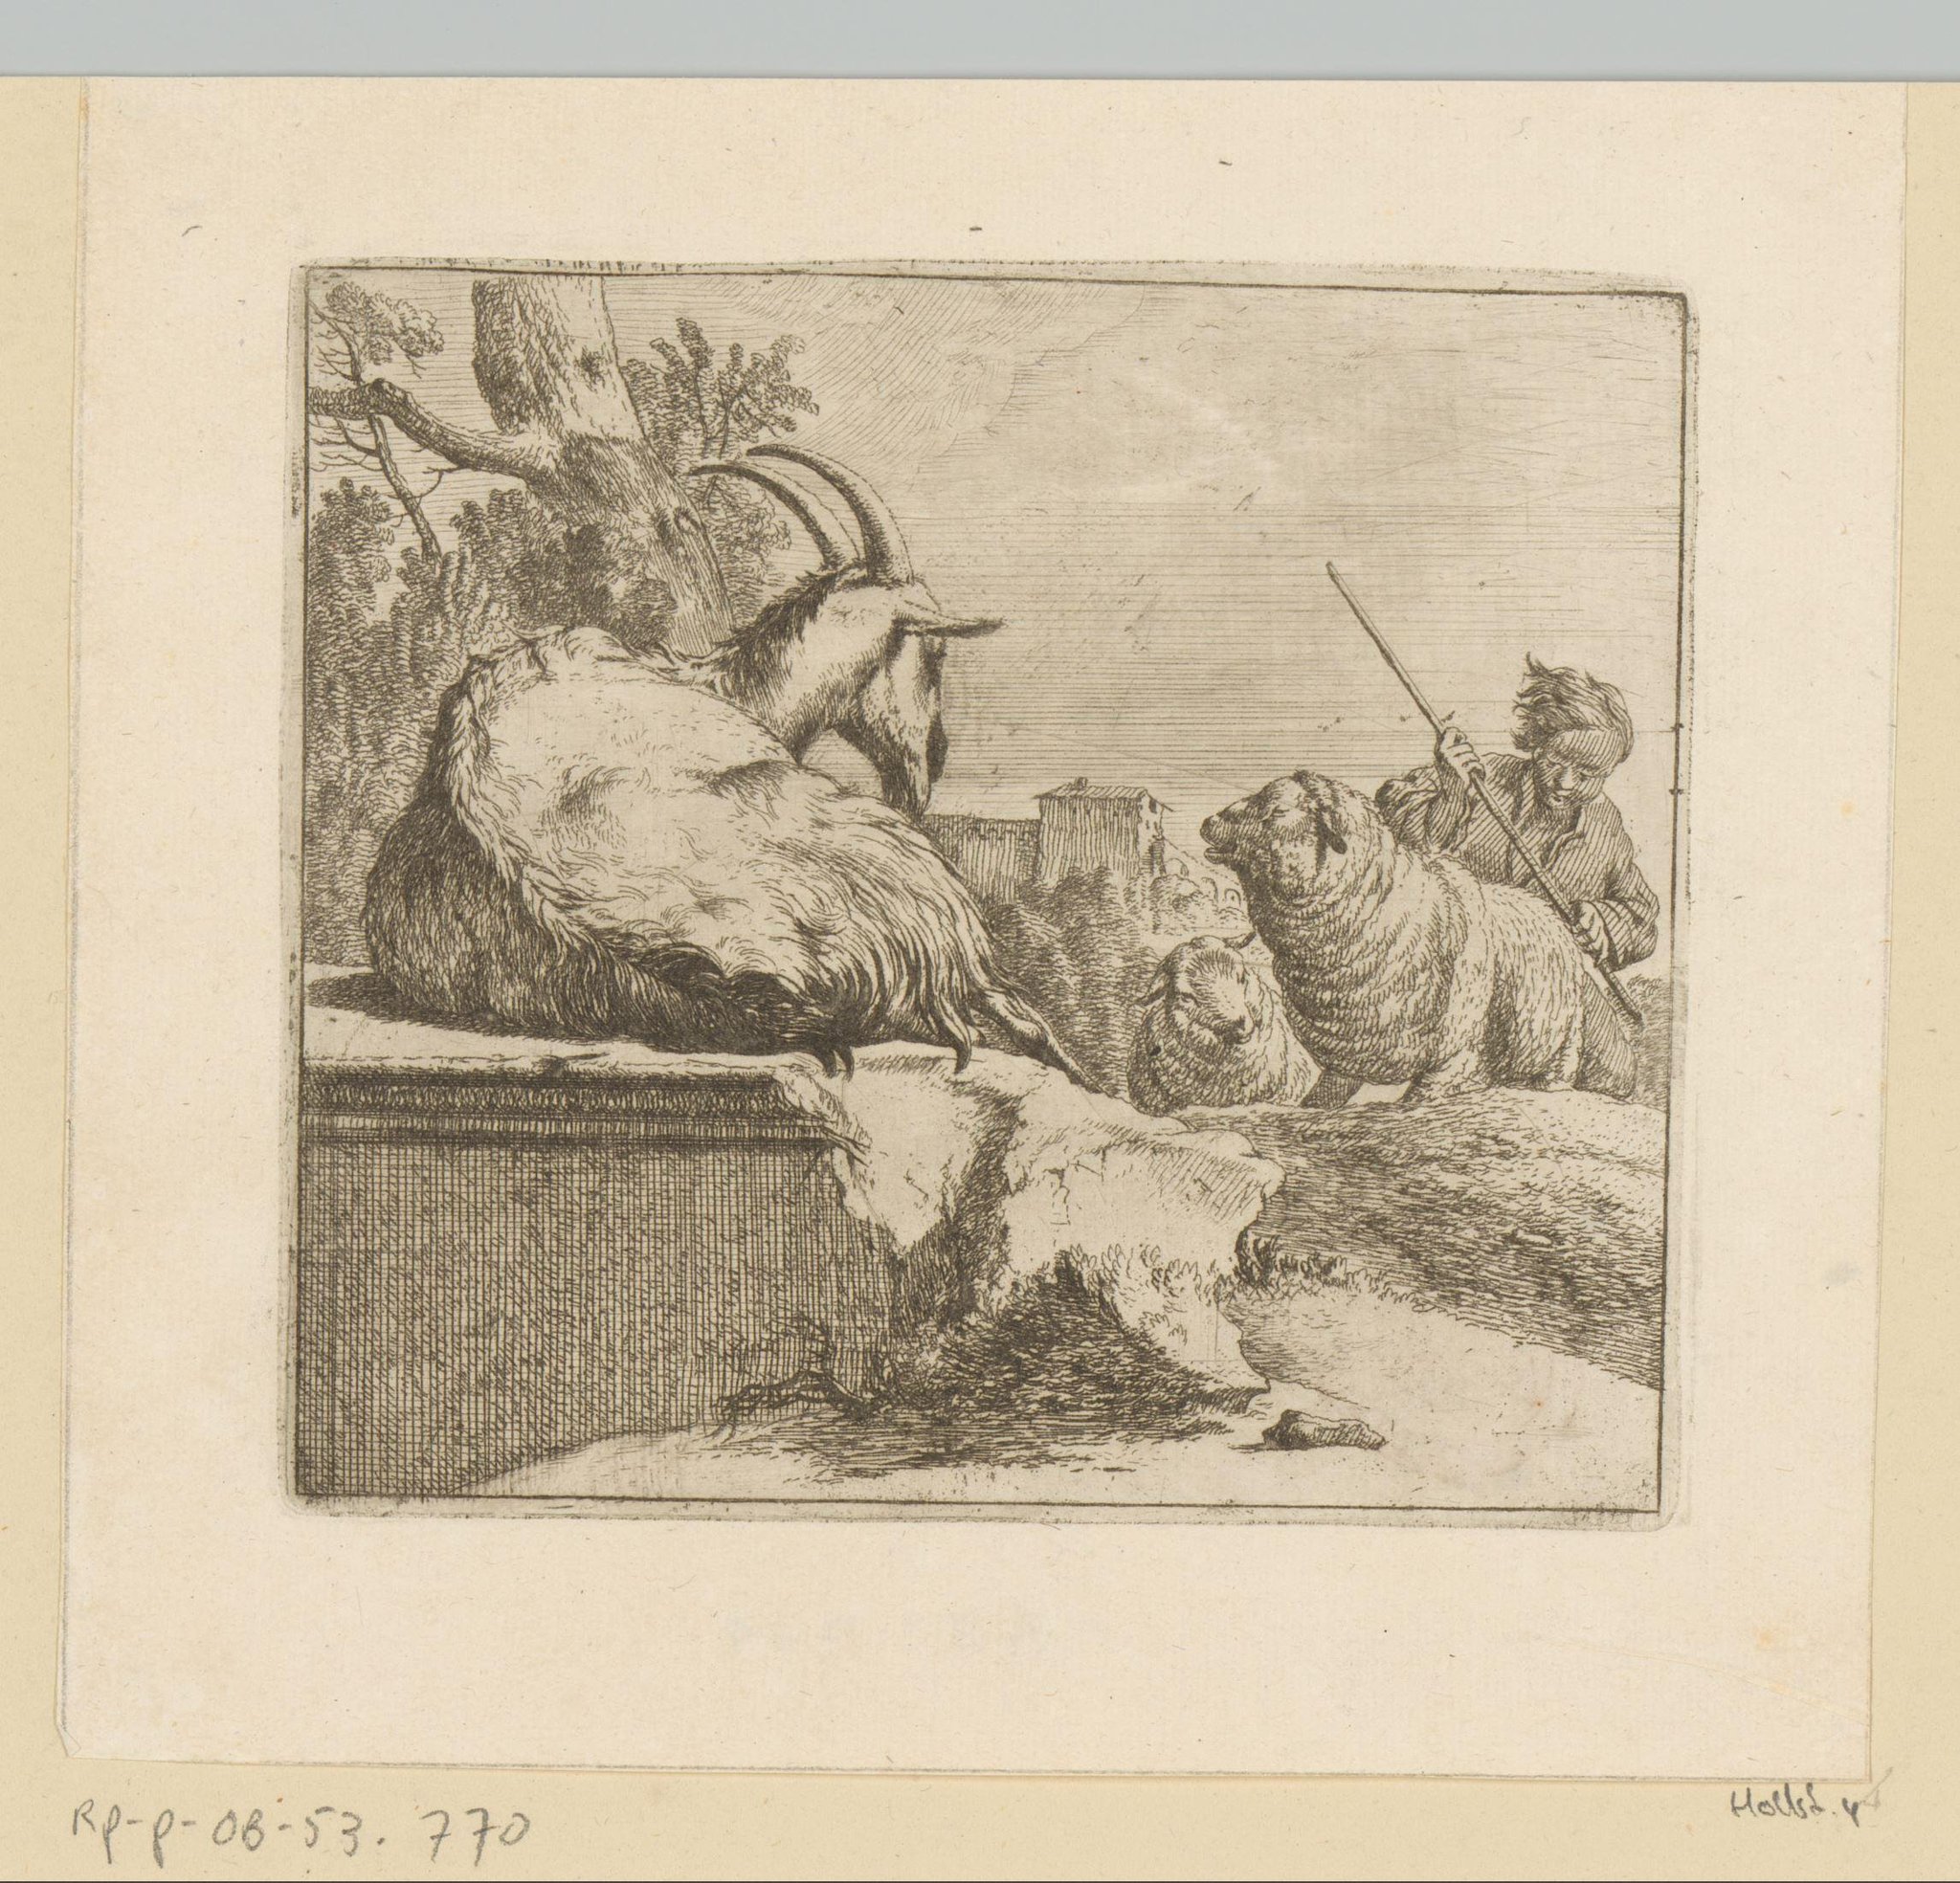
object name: print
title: Liggende geit en een herder met twee schapen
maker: johann heinrich roos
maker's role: draughtsman, print maker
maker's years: 1631-1685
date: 1671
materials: paper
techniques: engraving, etching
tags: landscapes, herding, herdsman, herdswoman, shepherd, shepherdess, cowherd, etc., sheep, goat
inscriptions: collector's mark: Lugt 240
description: Serie van negen prenten, waarvan één titelprent. Allen in de tweede, met de burijn bijgewerkte, staat.